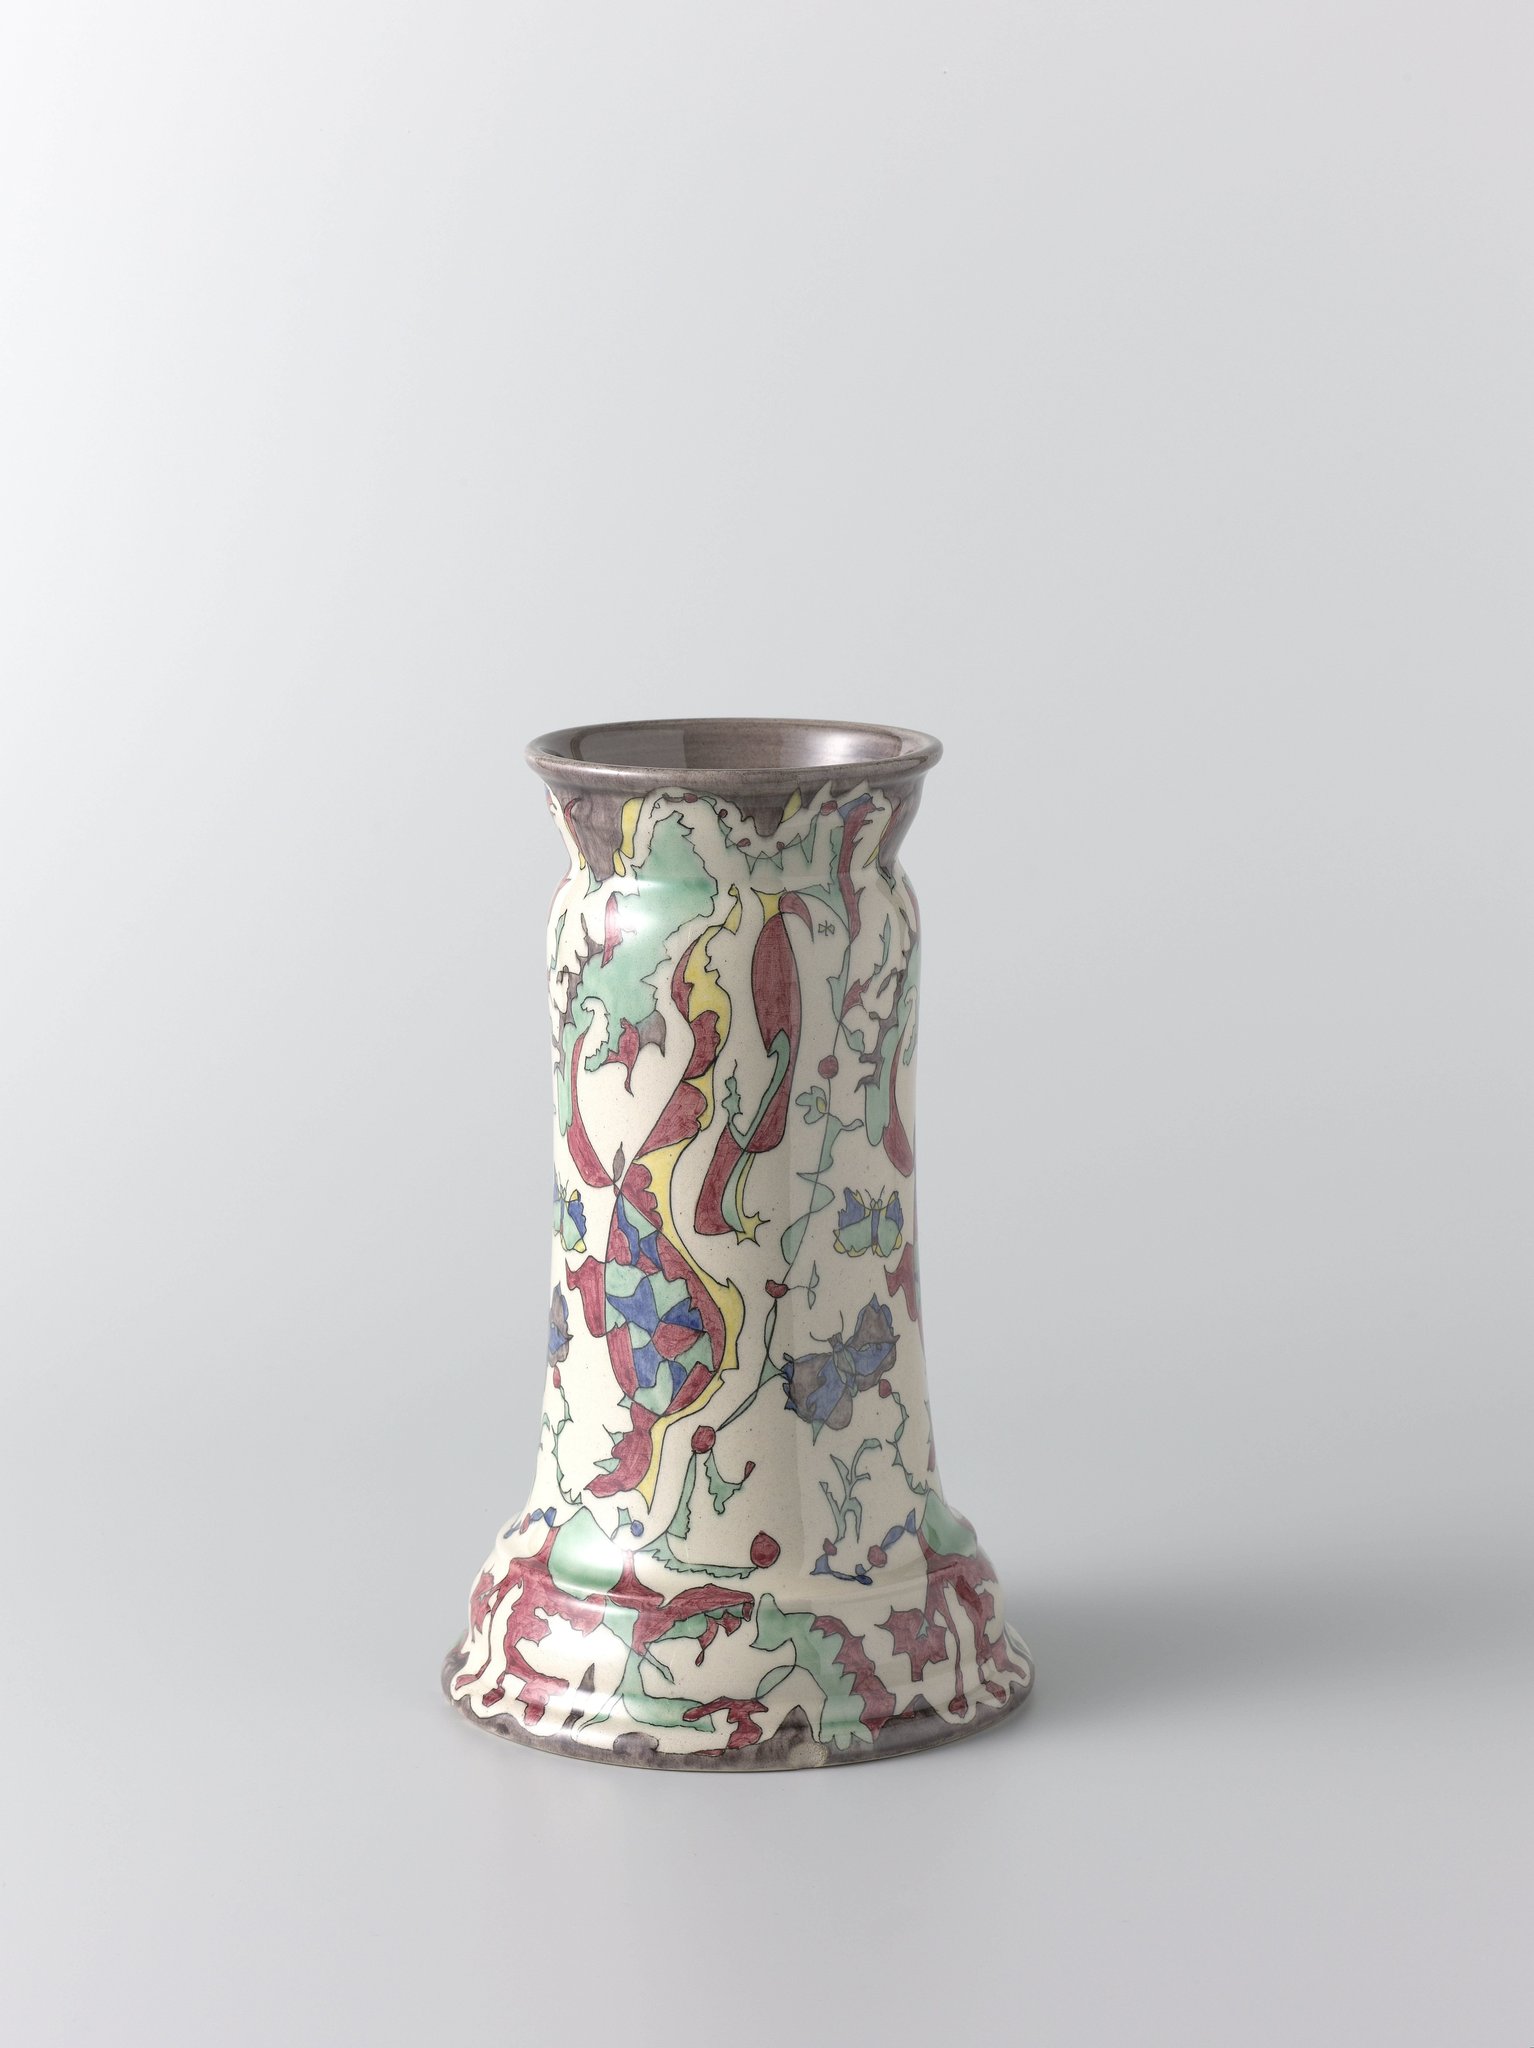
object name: vase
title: Vase with the ‘Onkruid’ (Weed) pattern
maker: theo colenbrander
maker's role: draughtsman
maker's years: 1841-1930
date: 1923-1927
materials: earthenware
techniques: painted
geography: arnhem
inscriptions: mark: ‘COLENBRANDER/RAM; ramskop met links en rechts ARNHEM HOLLAND/AARDEWERK, alles onder elkaar zonder cirkel; patroon ONKRUID; B; 29.F.v.B. en ingekrast het vormnummer 29.’